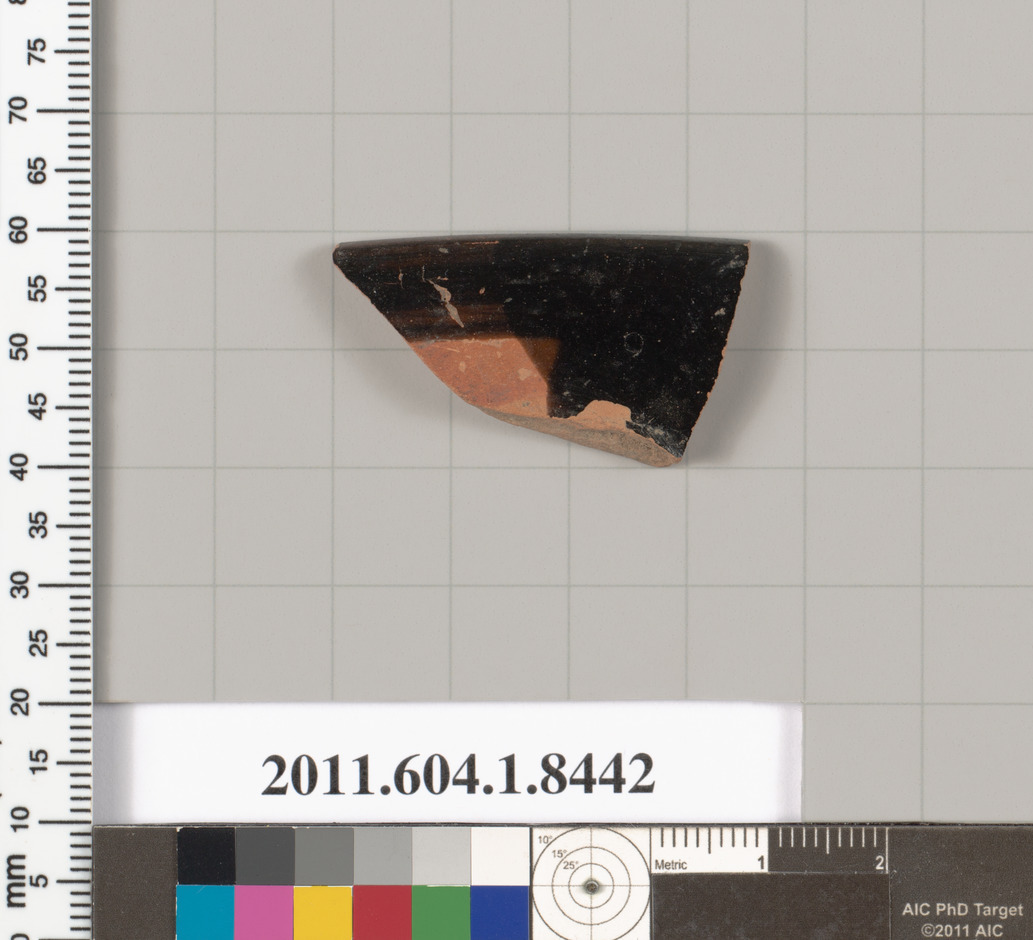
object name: kylix fragment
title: Terracotta rim fragment of a kylix (drinking cup)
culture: greek, attic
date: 400-351 BCE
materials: terracotta